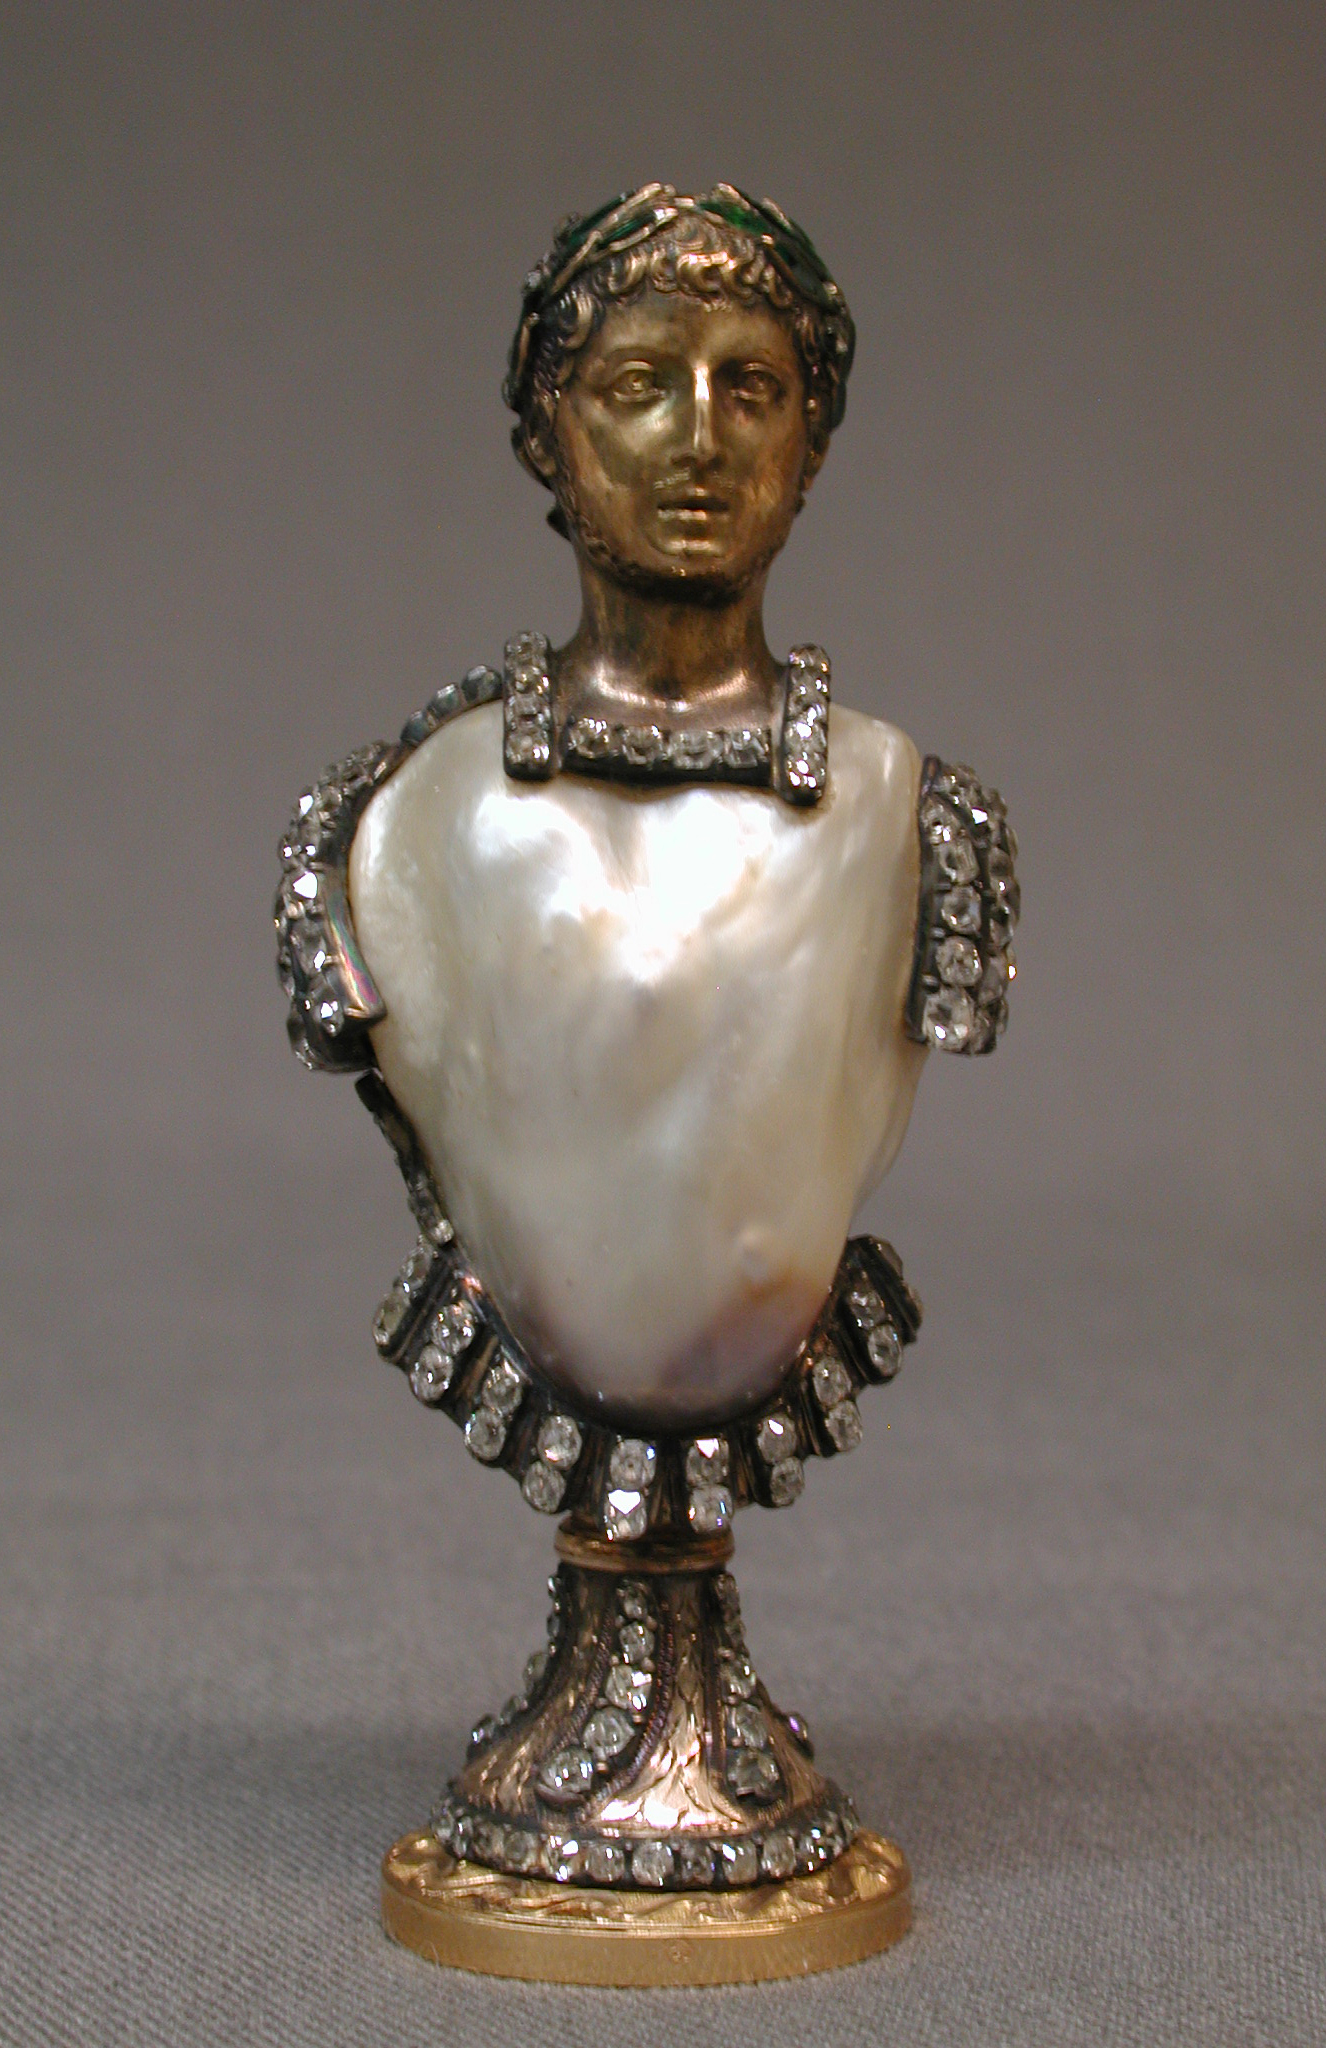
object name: seal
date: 1601-1800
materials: diamond, gemstone, gold, pearl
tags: heads,men